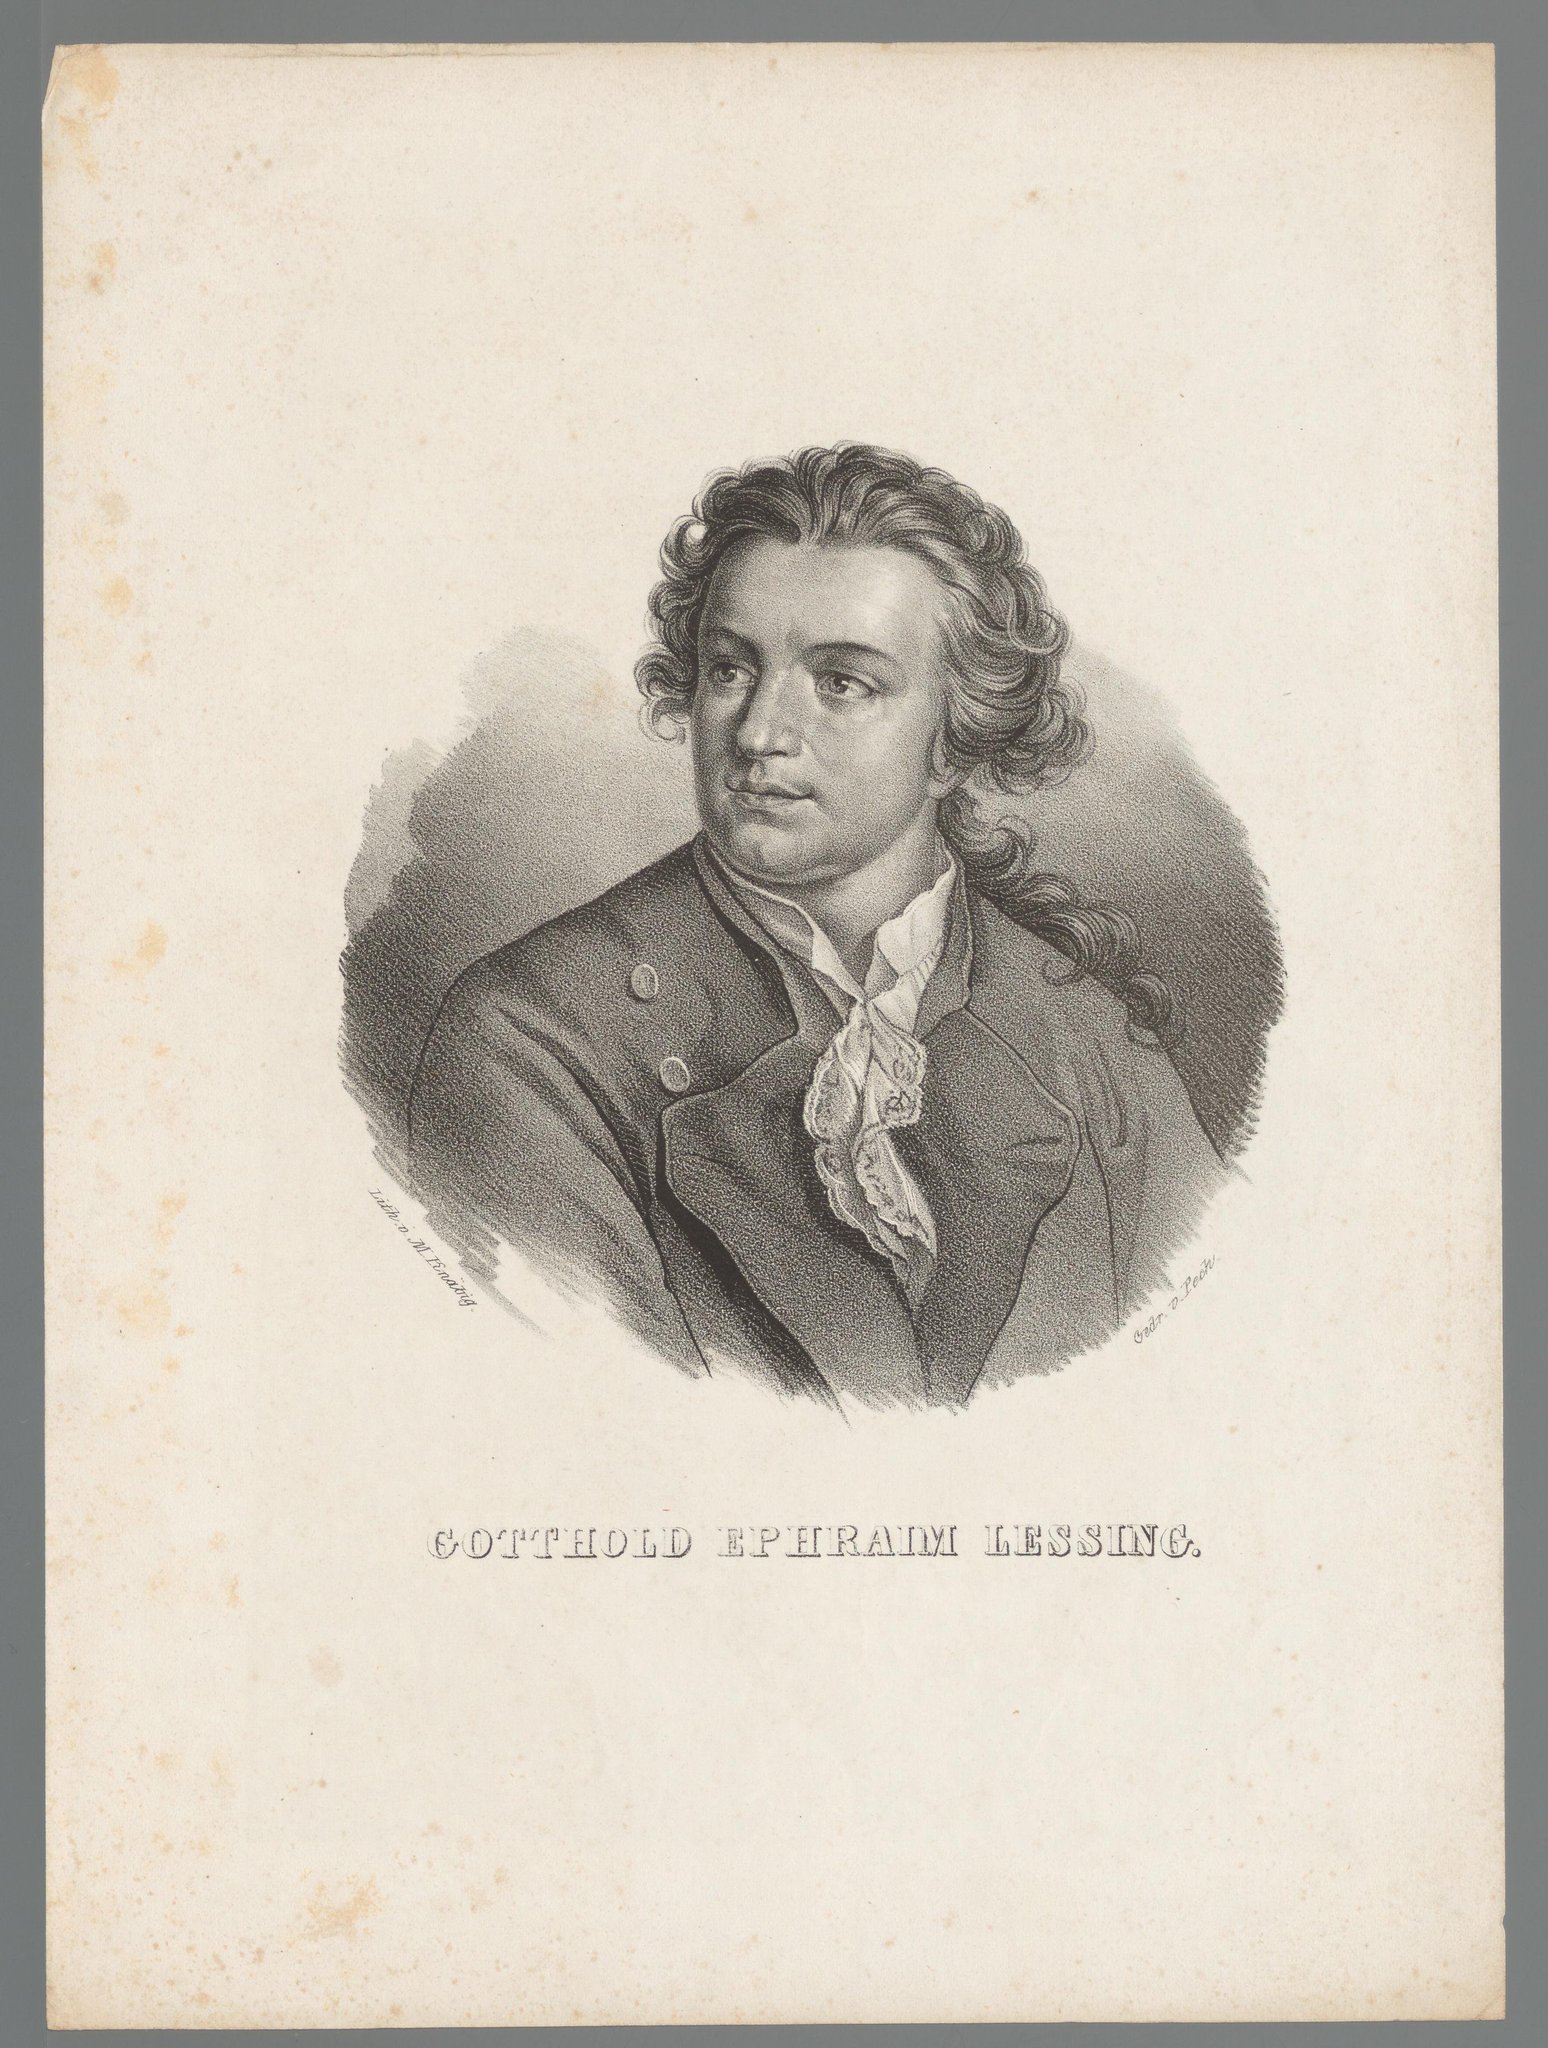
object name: print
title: Portret van Gotthold Ephraim Lessing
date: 1814-1876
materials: paper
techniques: lithograph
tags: adult man, historical persons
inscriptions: collector's mark: Lugt 2228